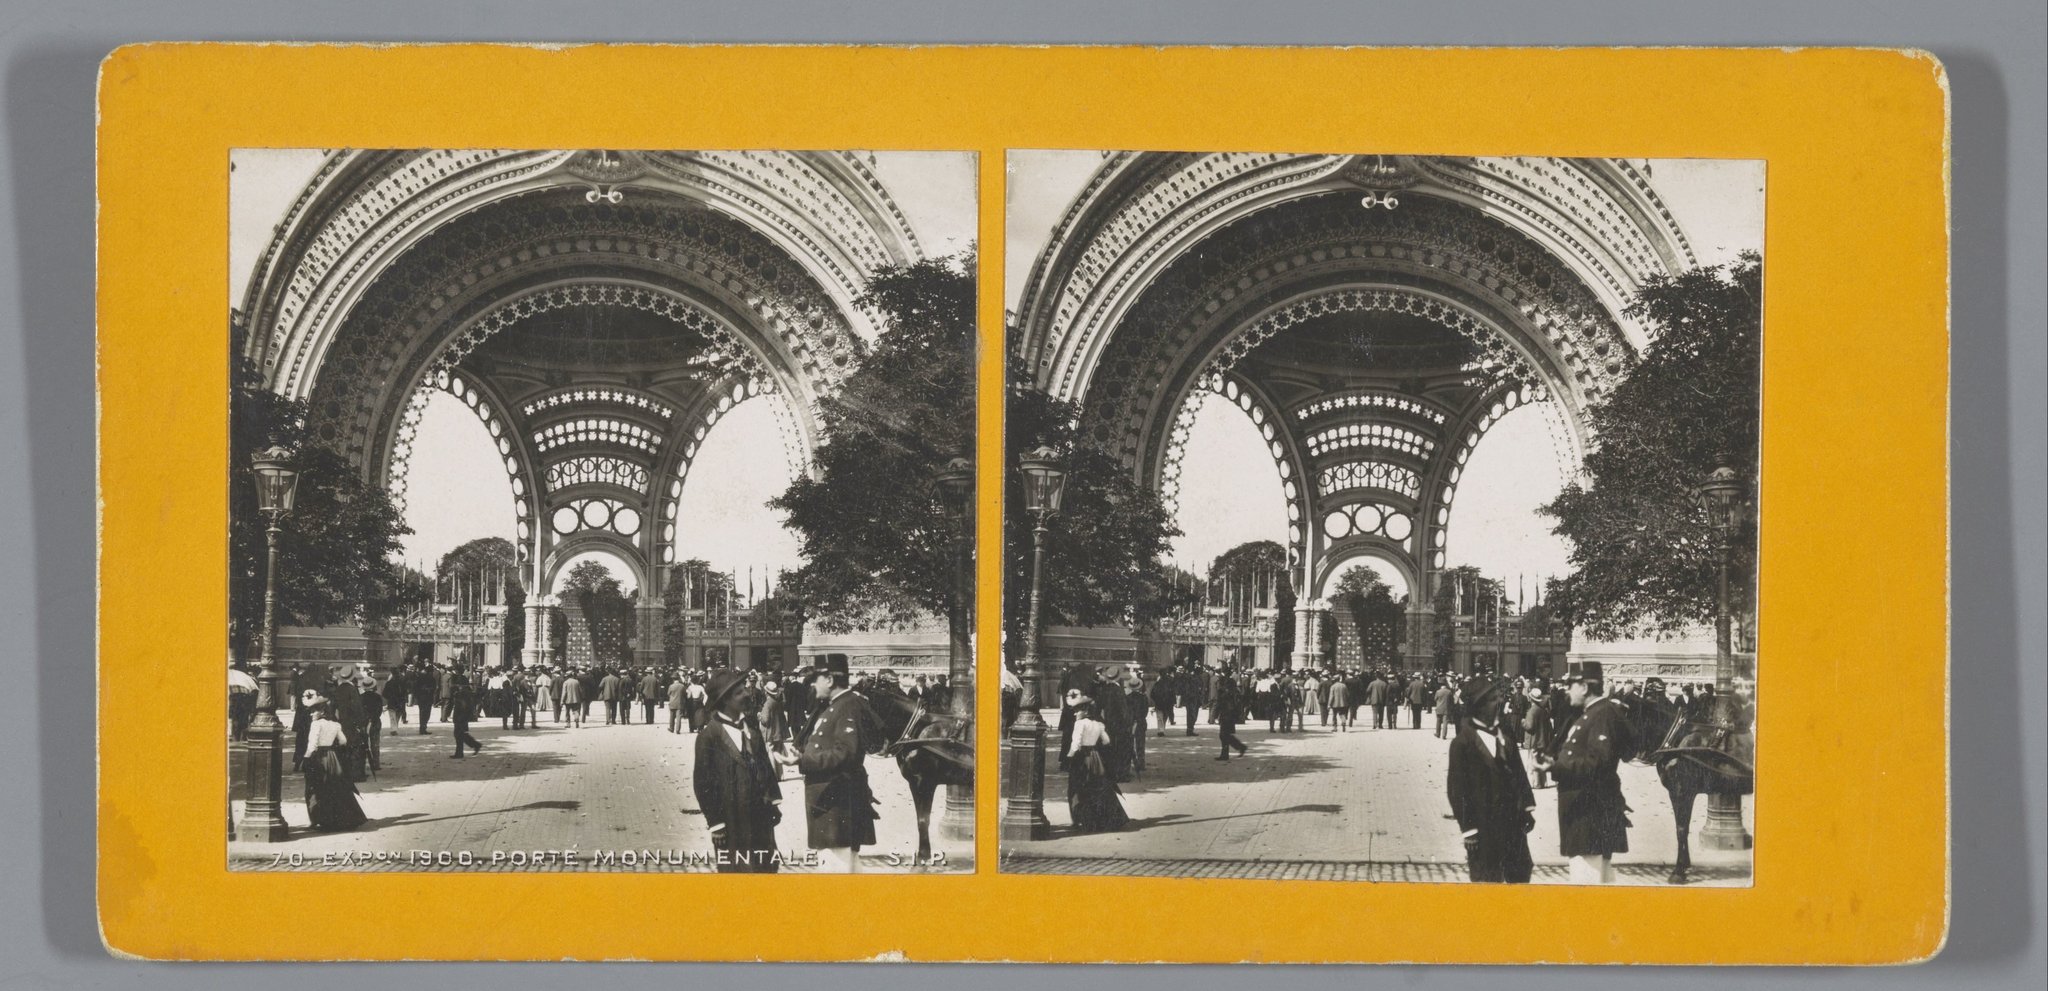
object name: stereograph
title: Expon 1900. Porté Monumentale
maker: Anonymous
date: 1900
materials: paper, cardboard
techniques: gelatin silver print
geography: rueil-malmaison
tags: world fair, world exhibition, arch, archivolt ~ architecture, paris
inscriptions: number: ‘70’